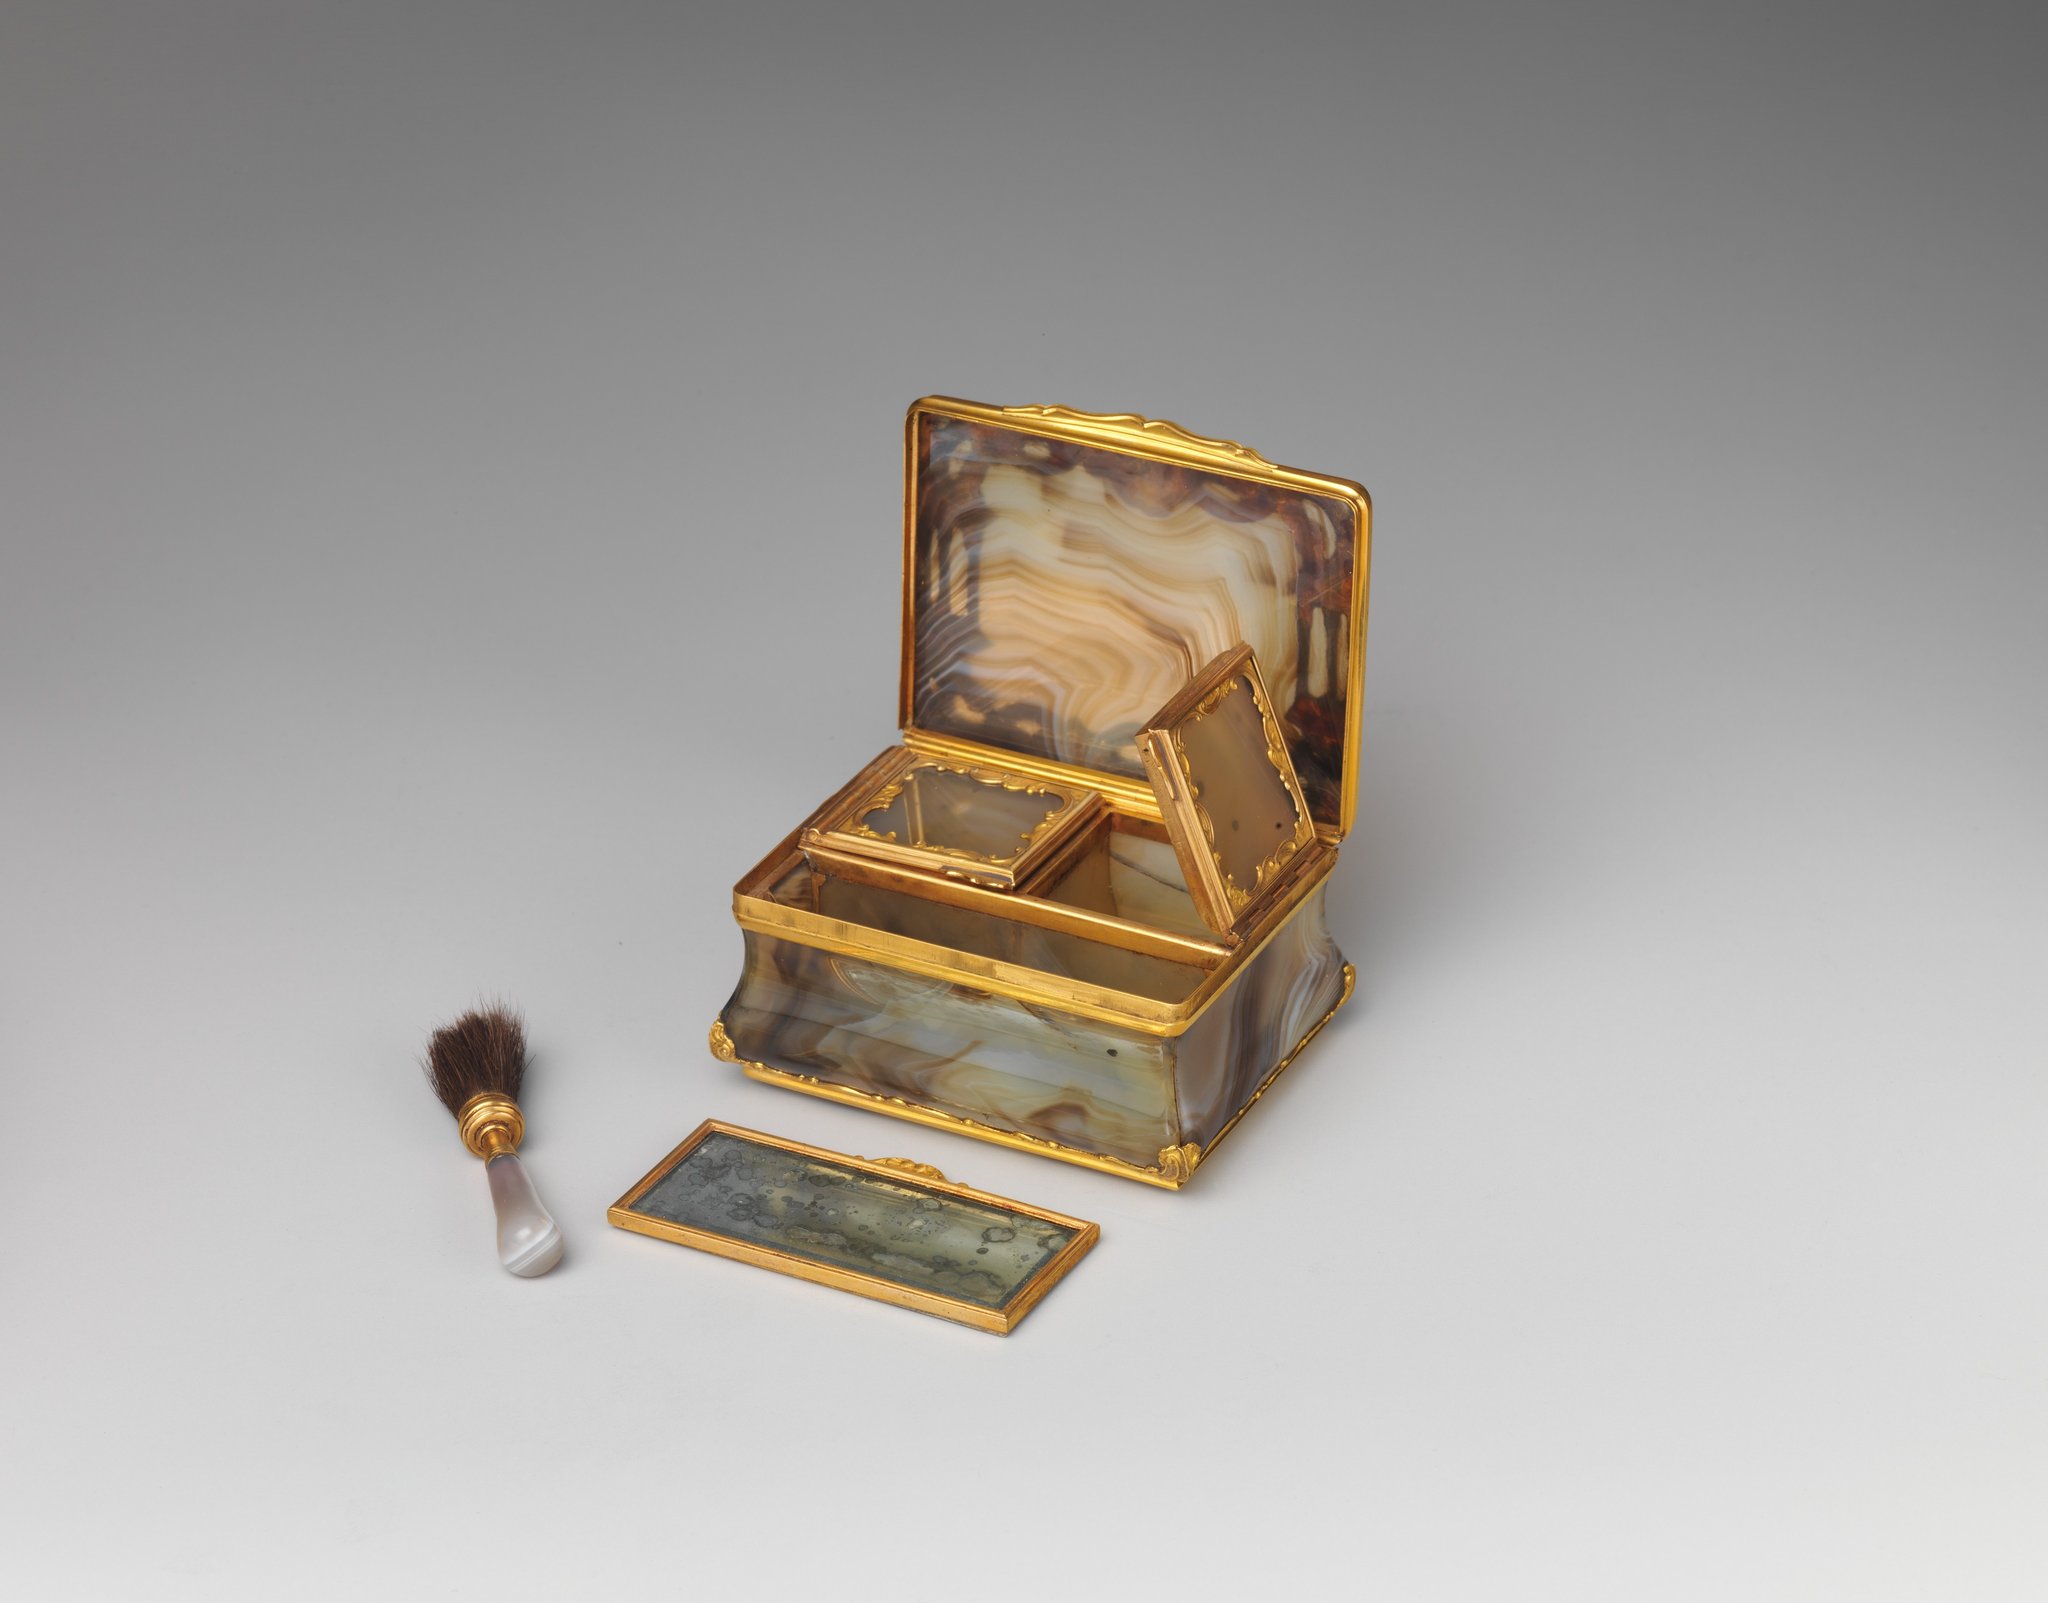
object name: box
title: Box for rouge and patches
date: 1750-1755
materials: stone, gold